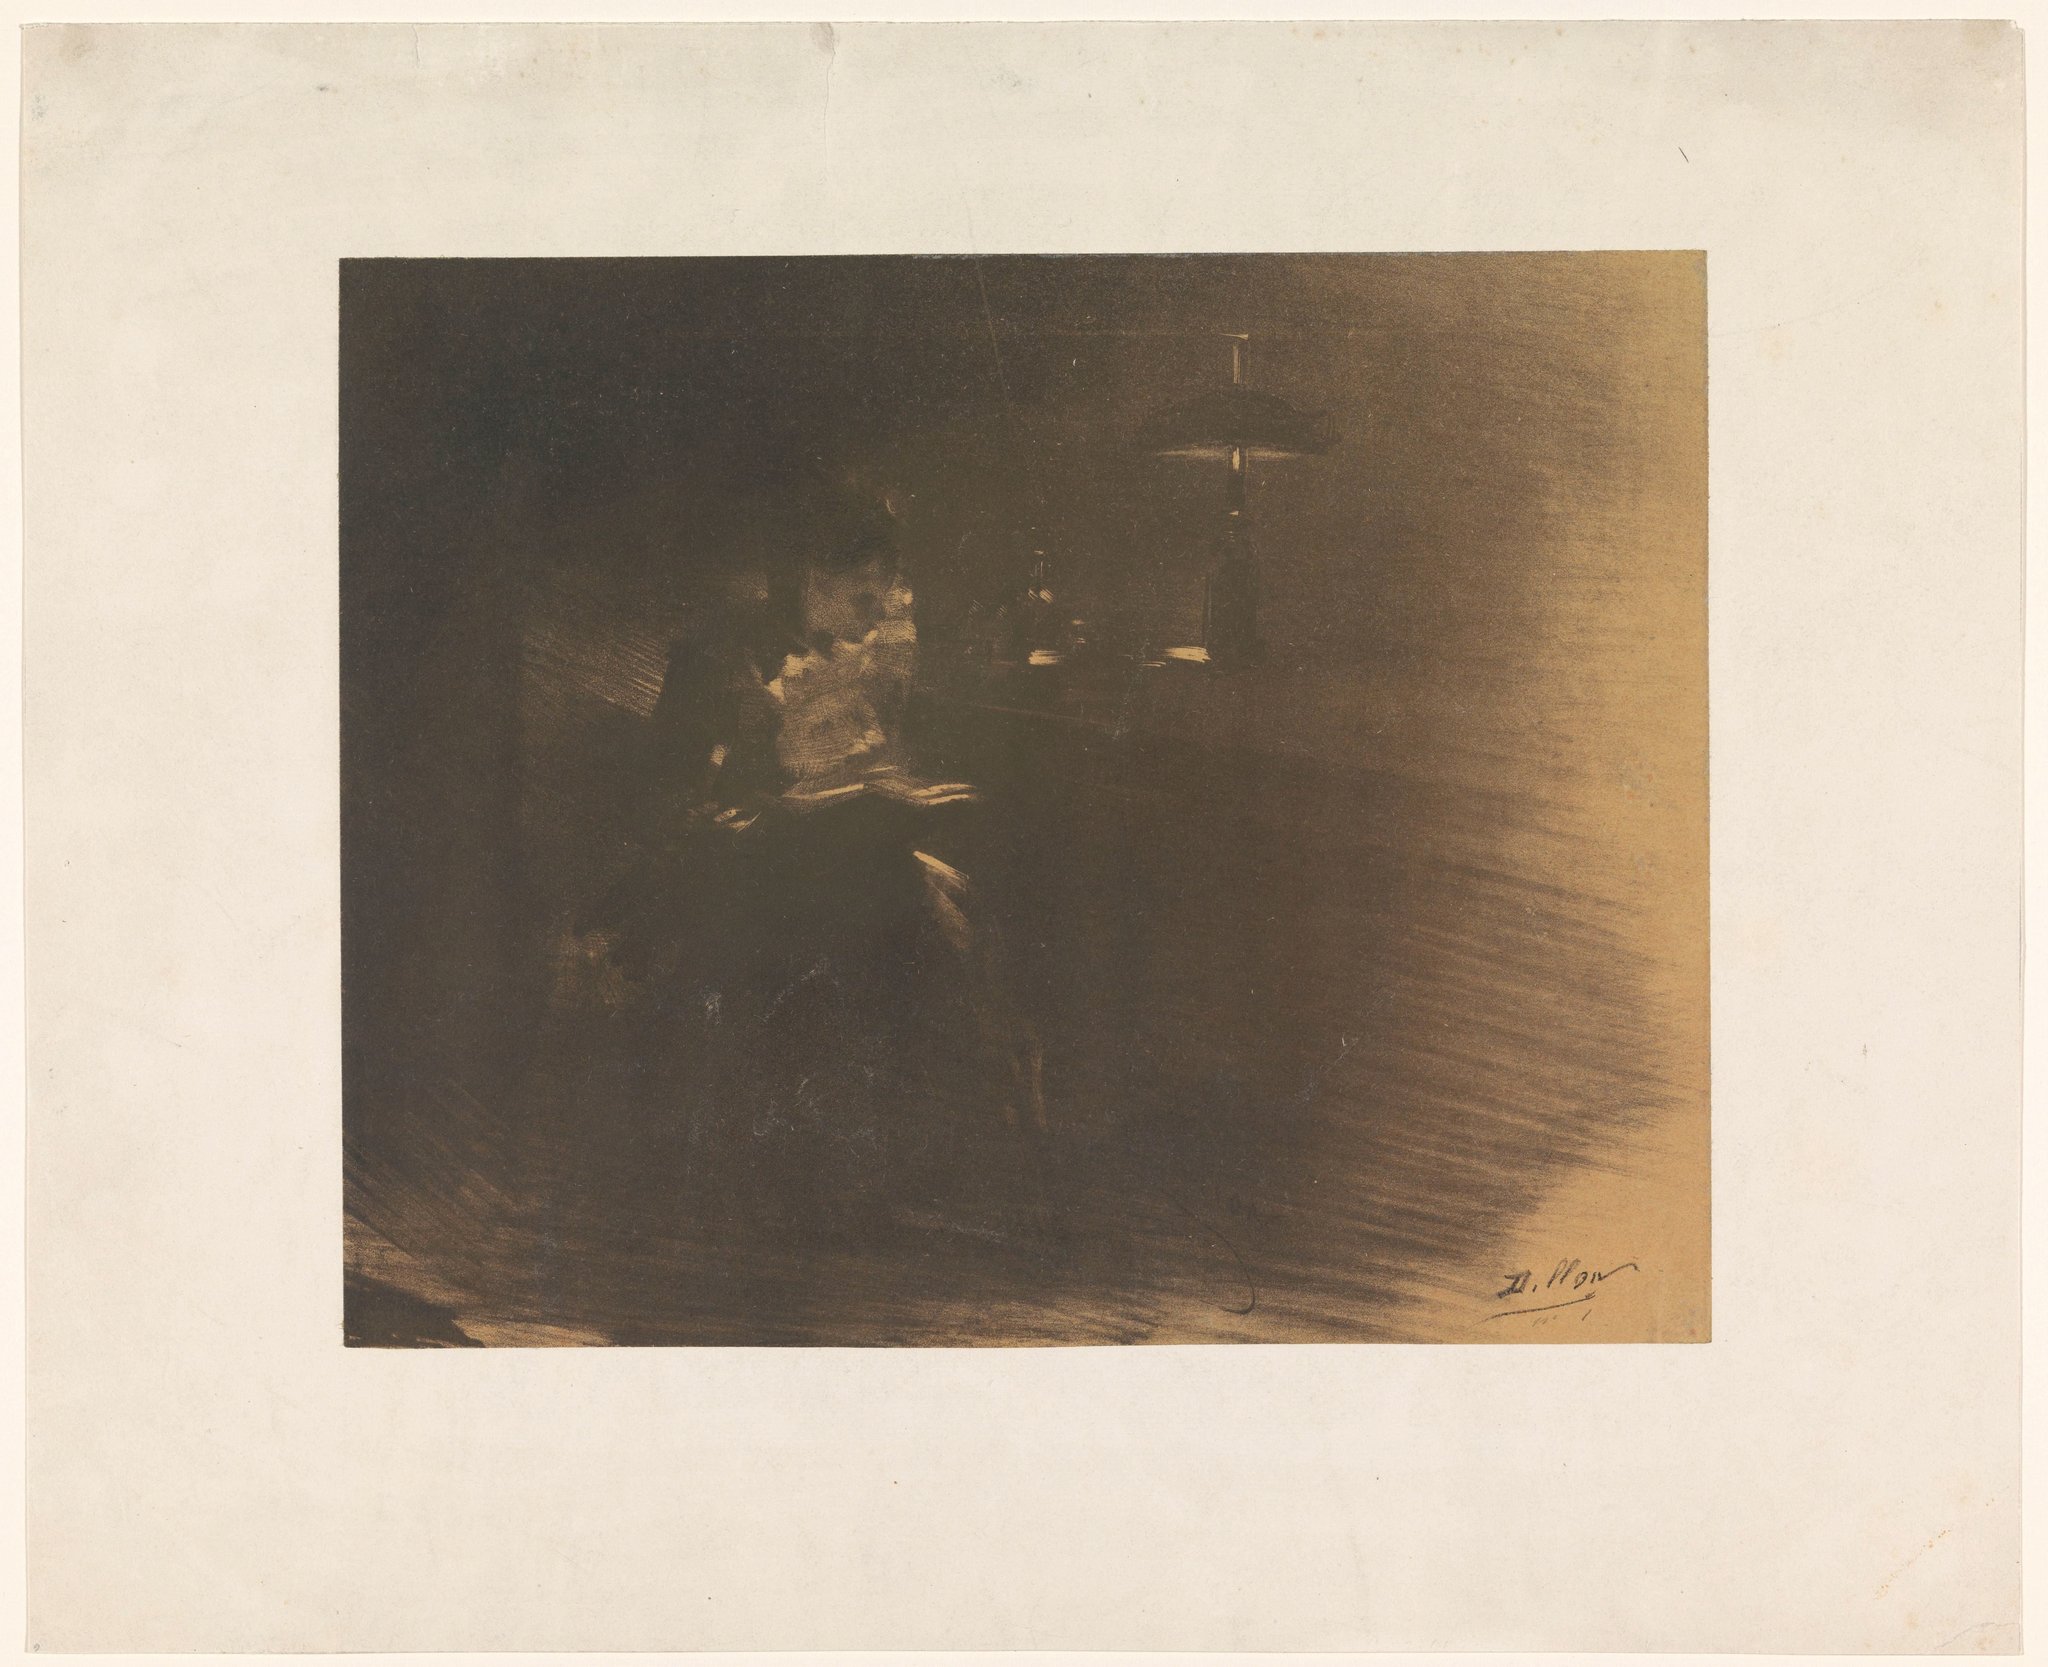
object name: print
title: Donker vertrek met een lezende vrouw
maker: henri patrice dillon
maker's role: print maker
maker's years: 1850-1909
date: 1860-1909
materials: paper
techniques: lithograph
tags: reading, lighting; lamps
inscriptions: signature: ‘Dillon’, collector's mark, collector's mark: Lugt 2228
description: Op de tafel naast de vrouw staat een lamp.